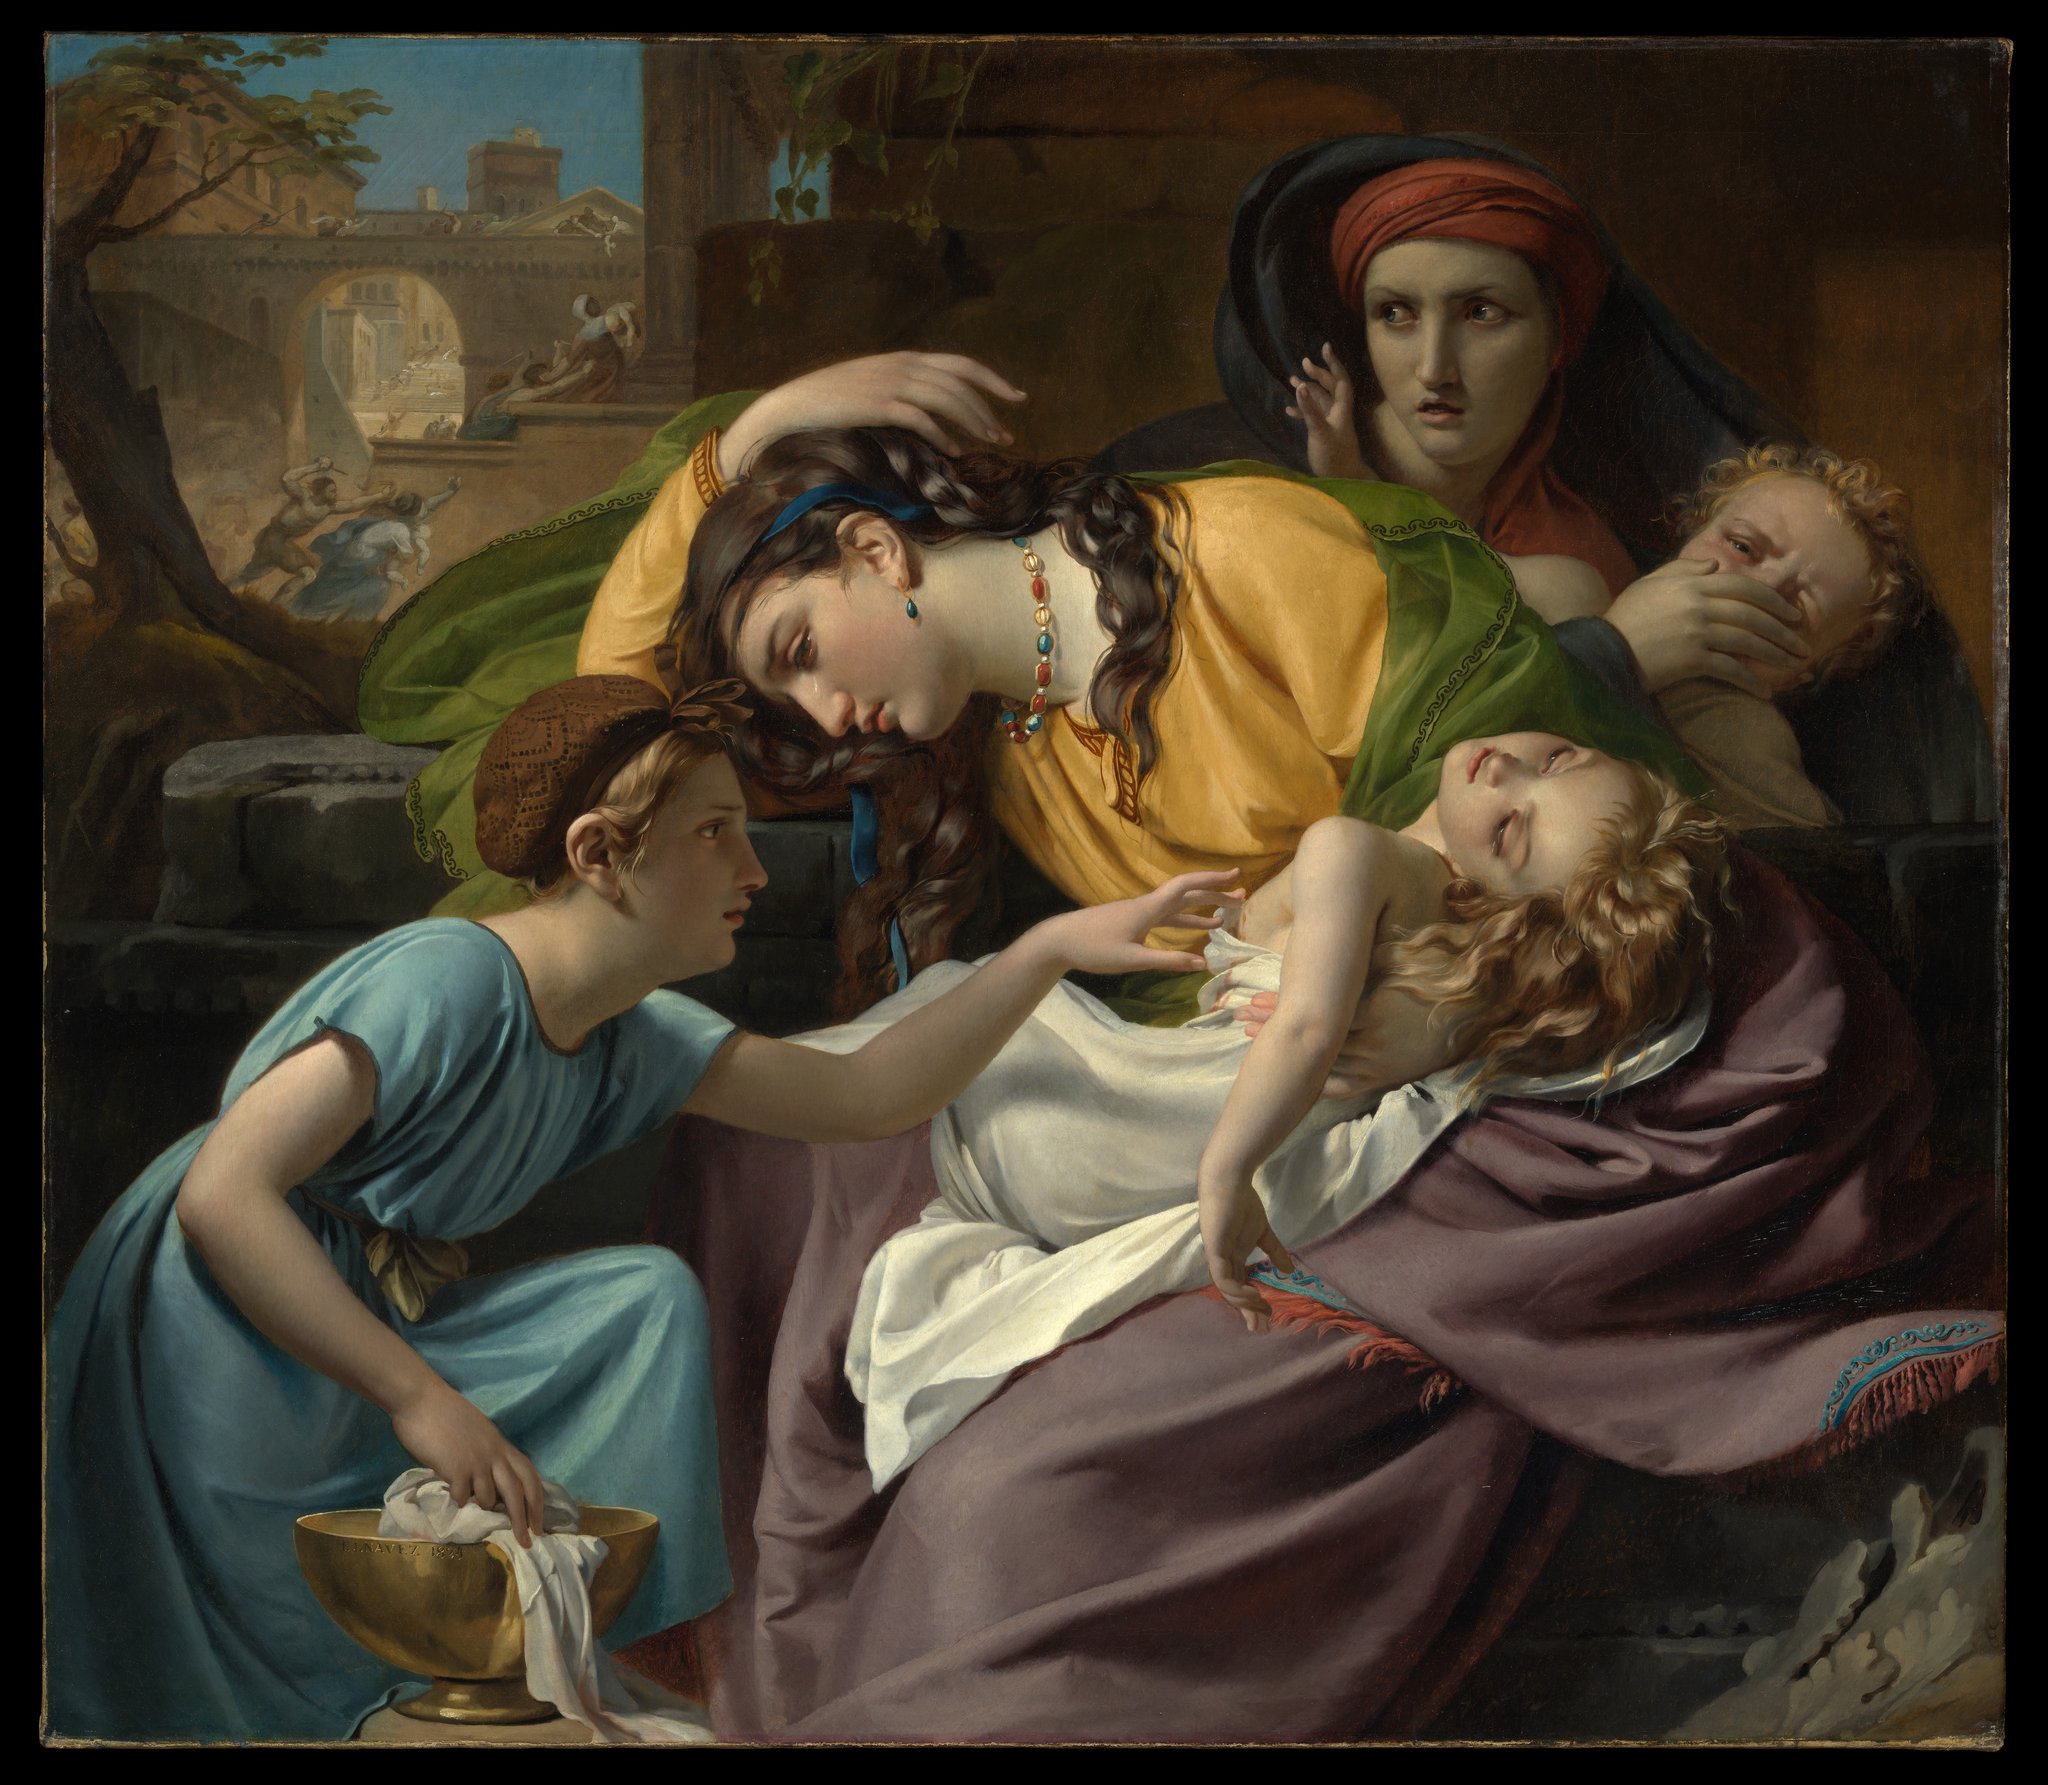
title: The Massacre of the Innocents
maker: françois joseph navez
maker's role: artist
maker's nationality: belgian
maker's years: 1787-1869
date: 1824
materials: canvas, oil